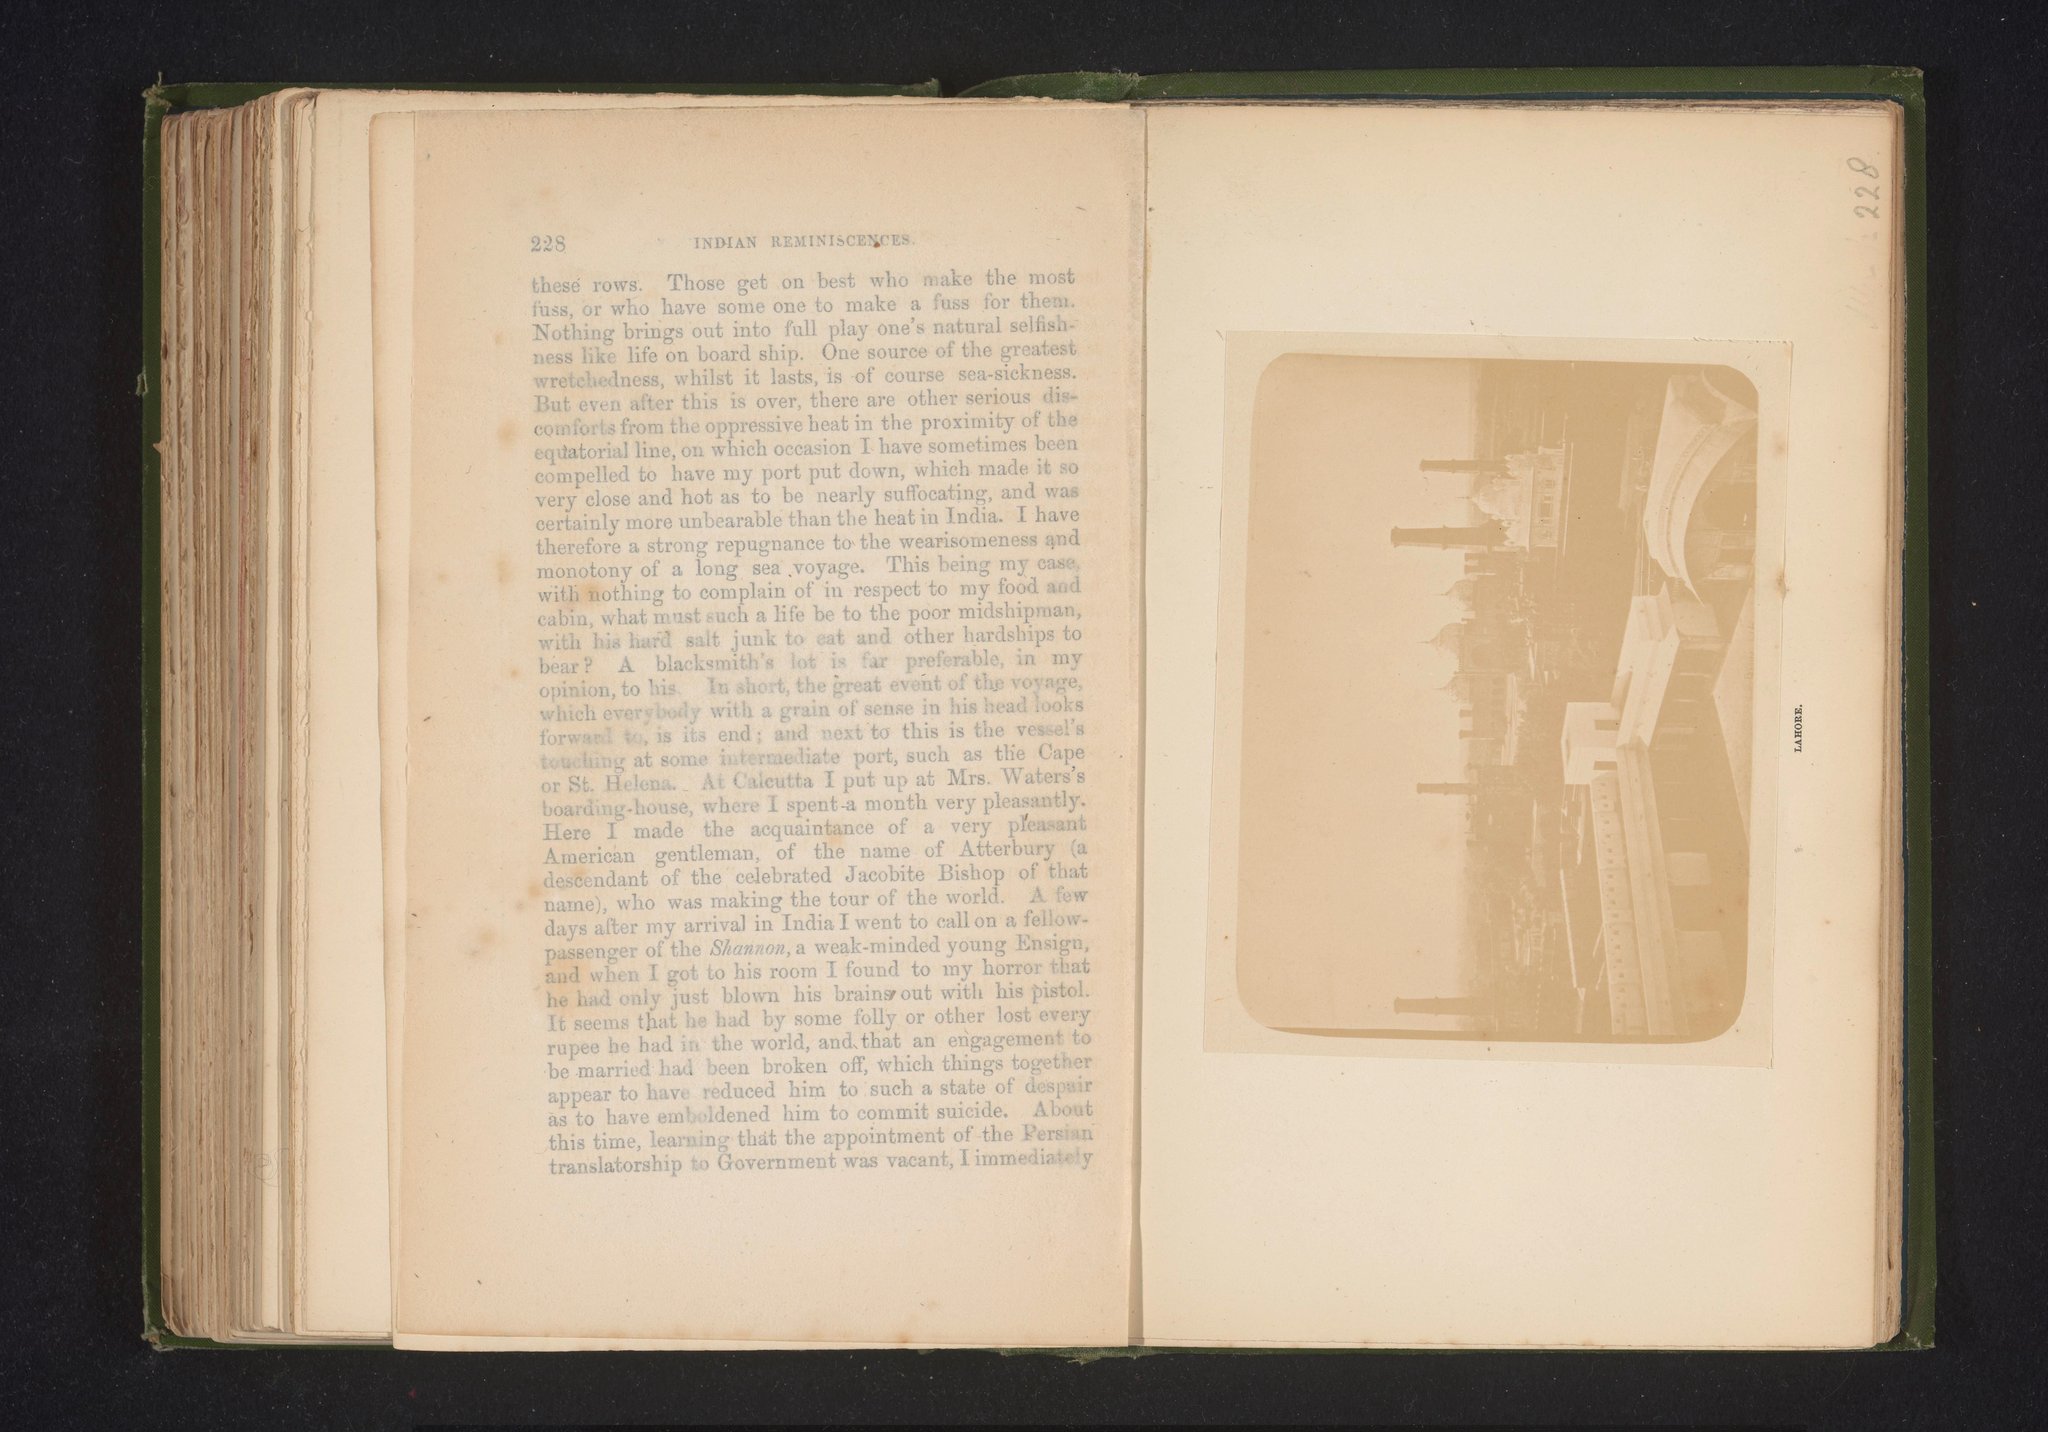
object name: page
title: Lahore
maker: Anonymous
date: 1870-1880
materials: photographic support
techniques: albumen print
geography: lahore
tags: city-view in general; 'veduta'